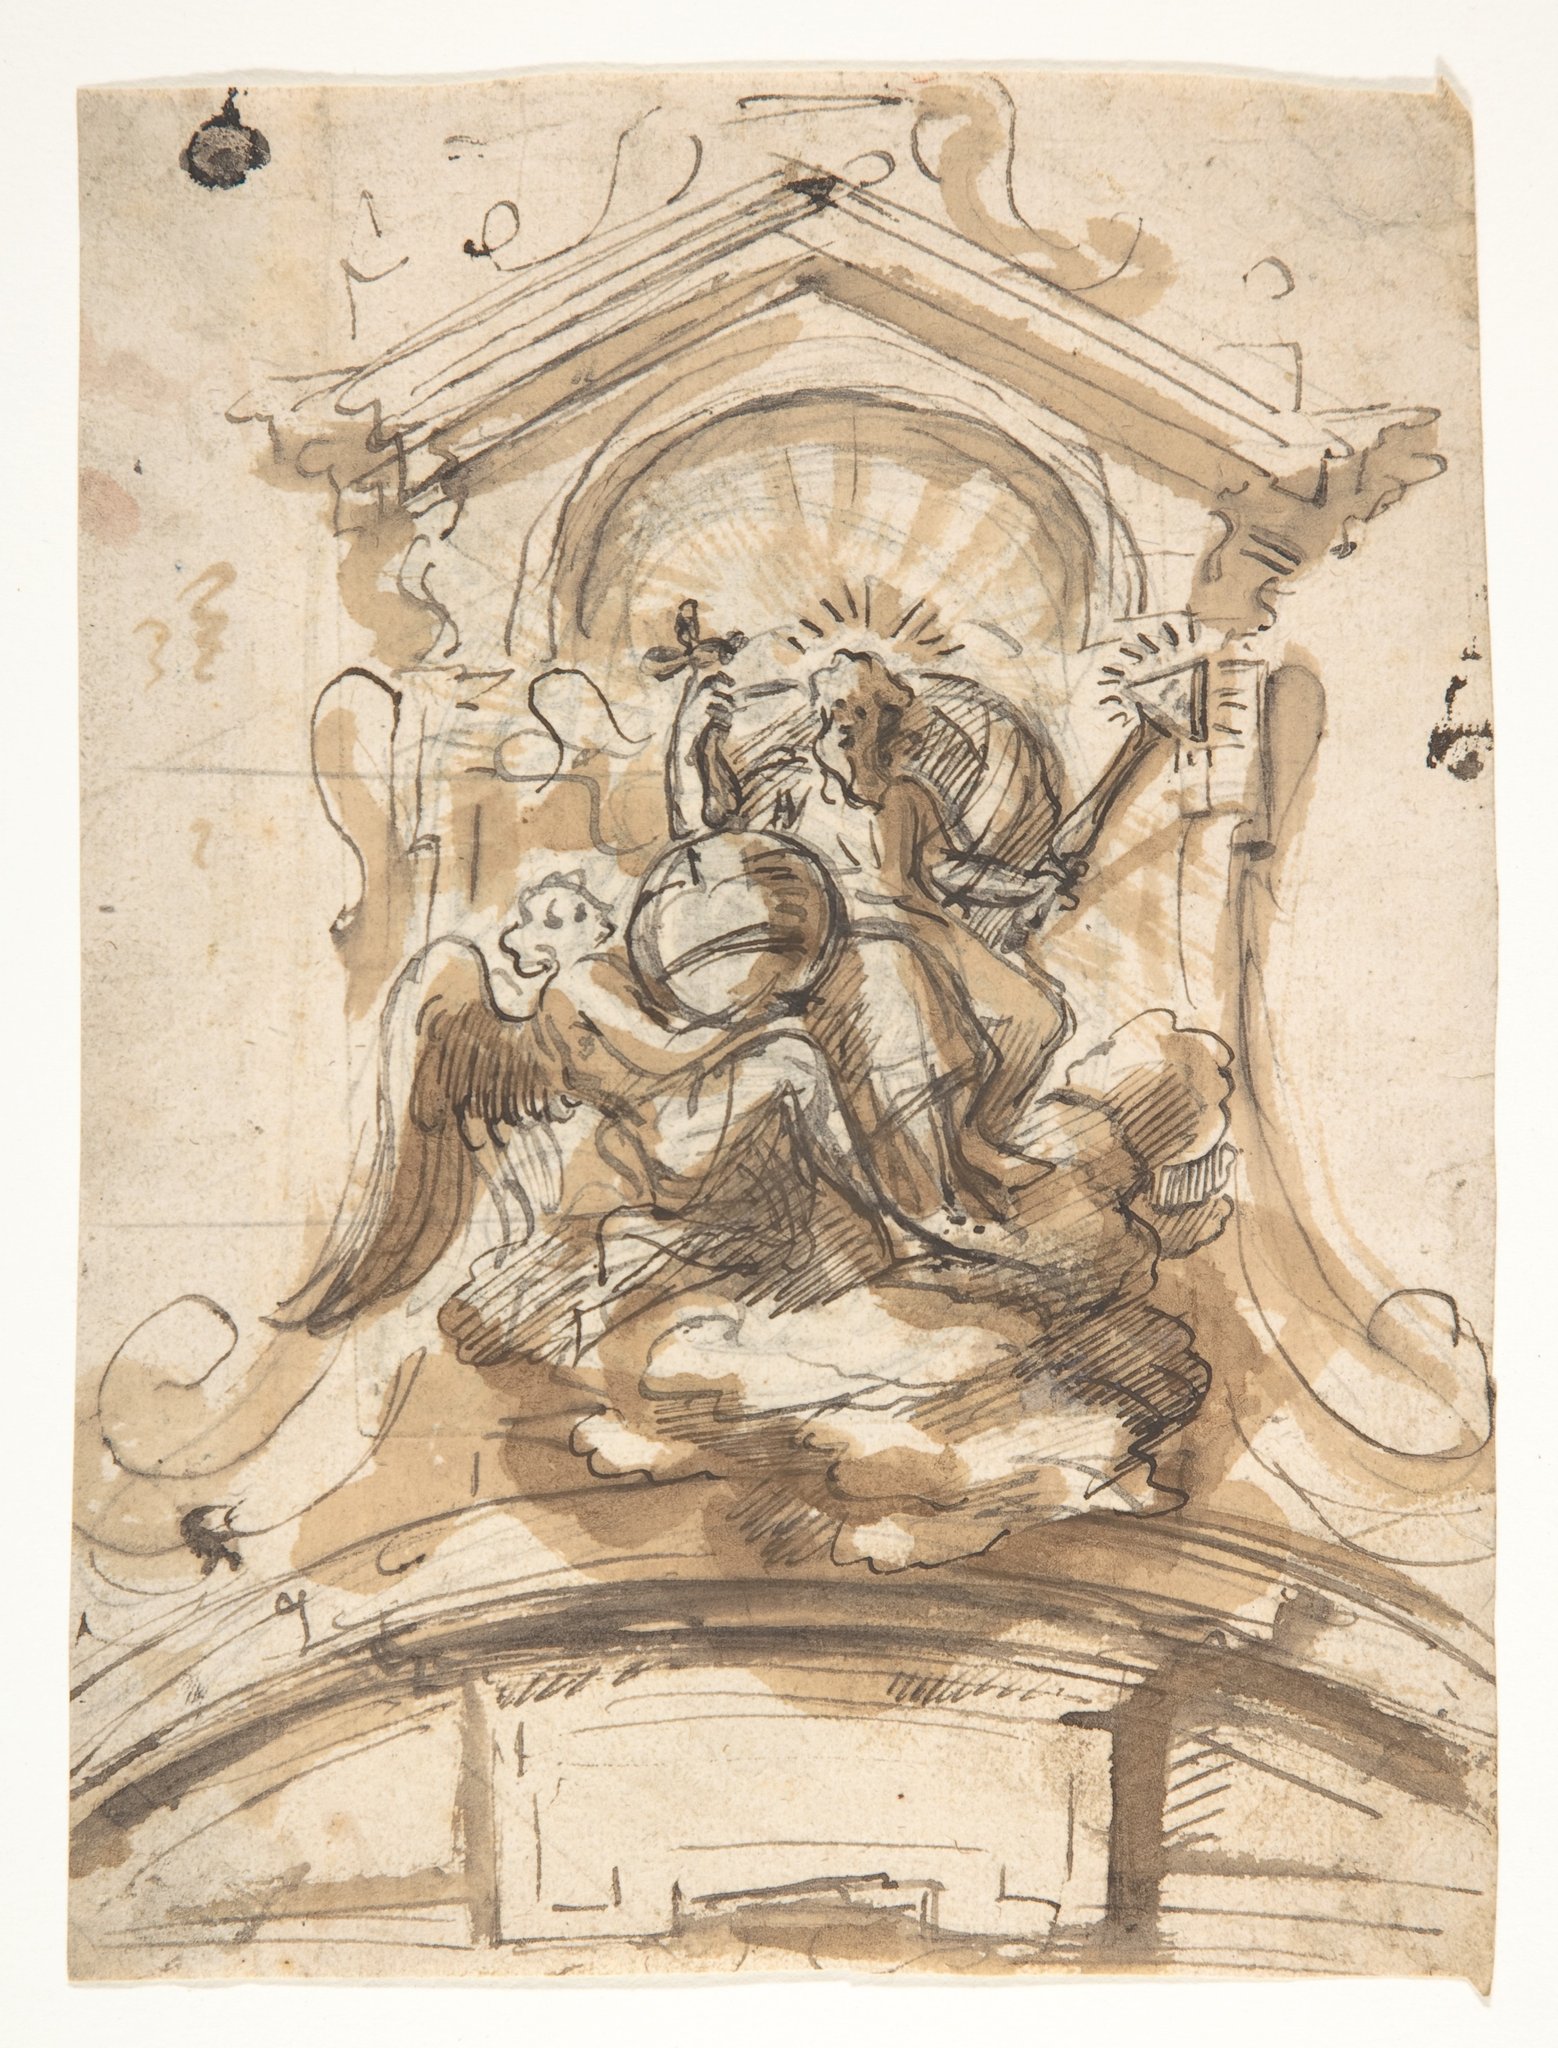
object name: drawing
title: Design for a sculptural group with God the Father in a niche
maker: pieter verbruggen the younger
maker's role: artist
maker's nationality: flemish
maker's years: 1648-1691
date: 1667-1733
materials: chalk, graphite, ink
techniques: brush, pen, wash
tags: angels,god the father